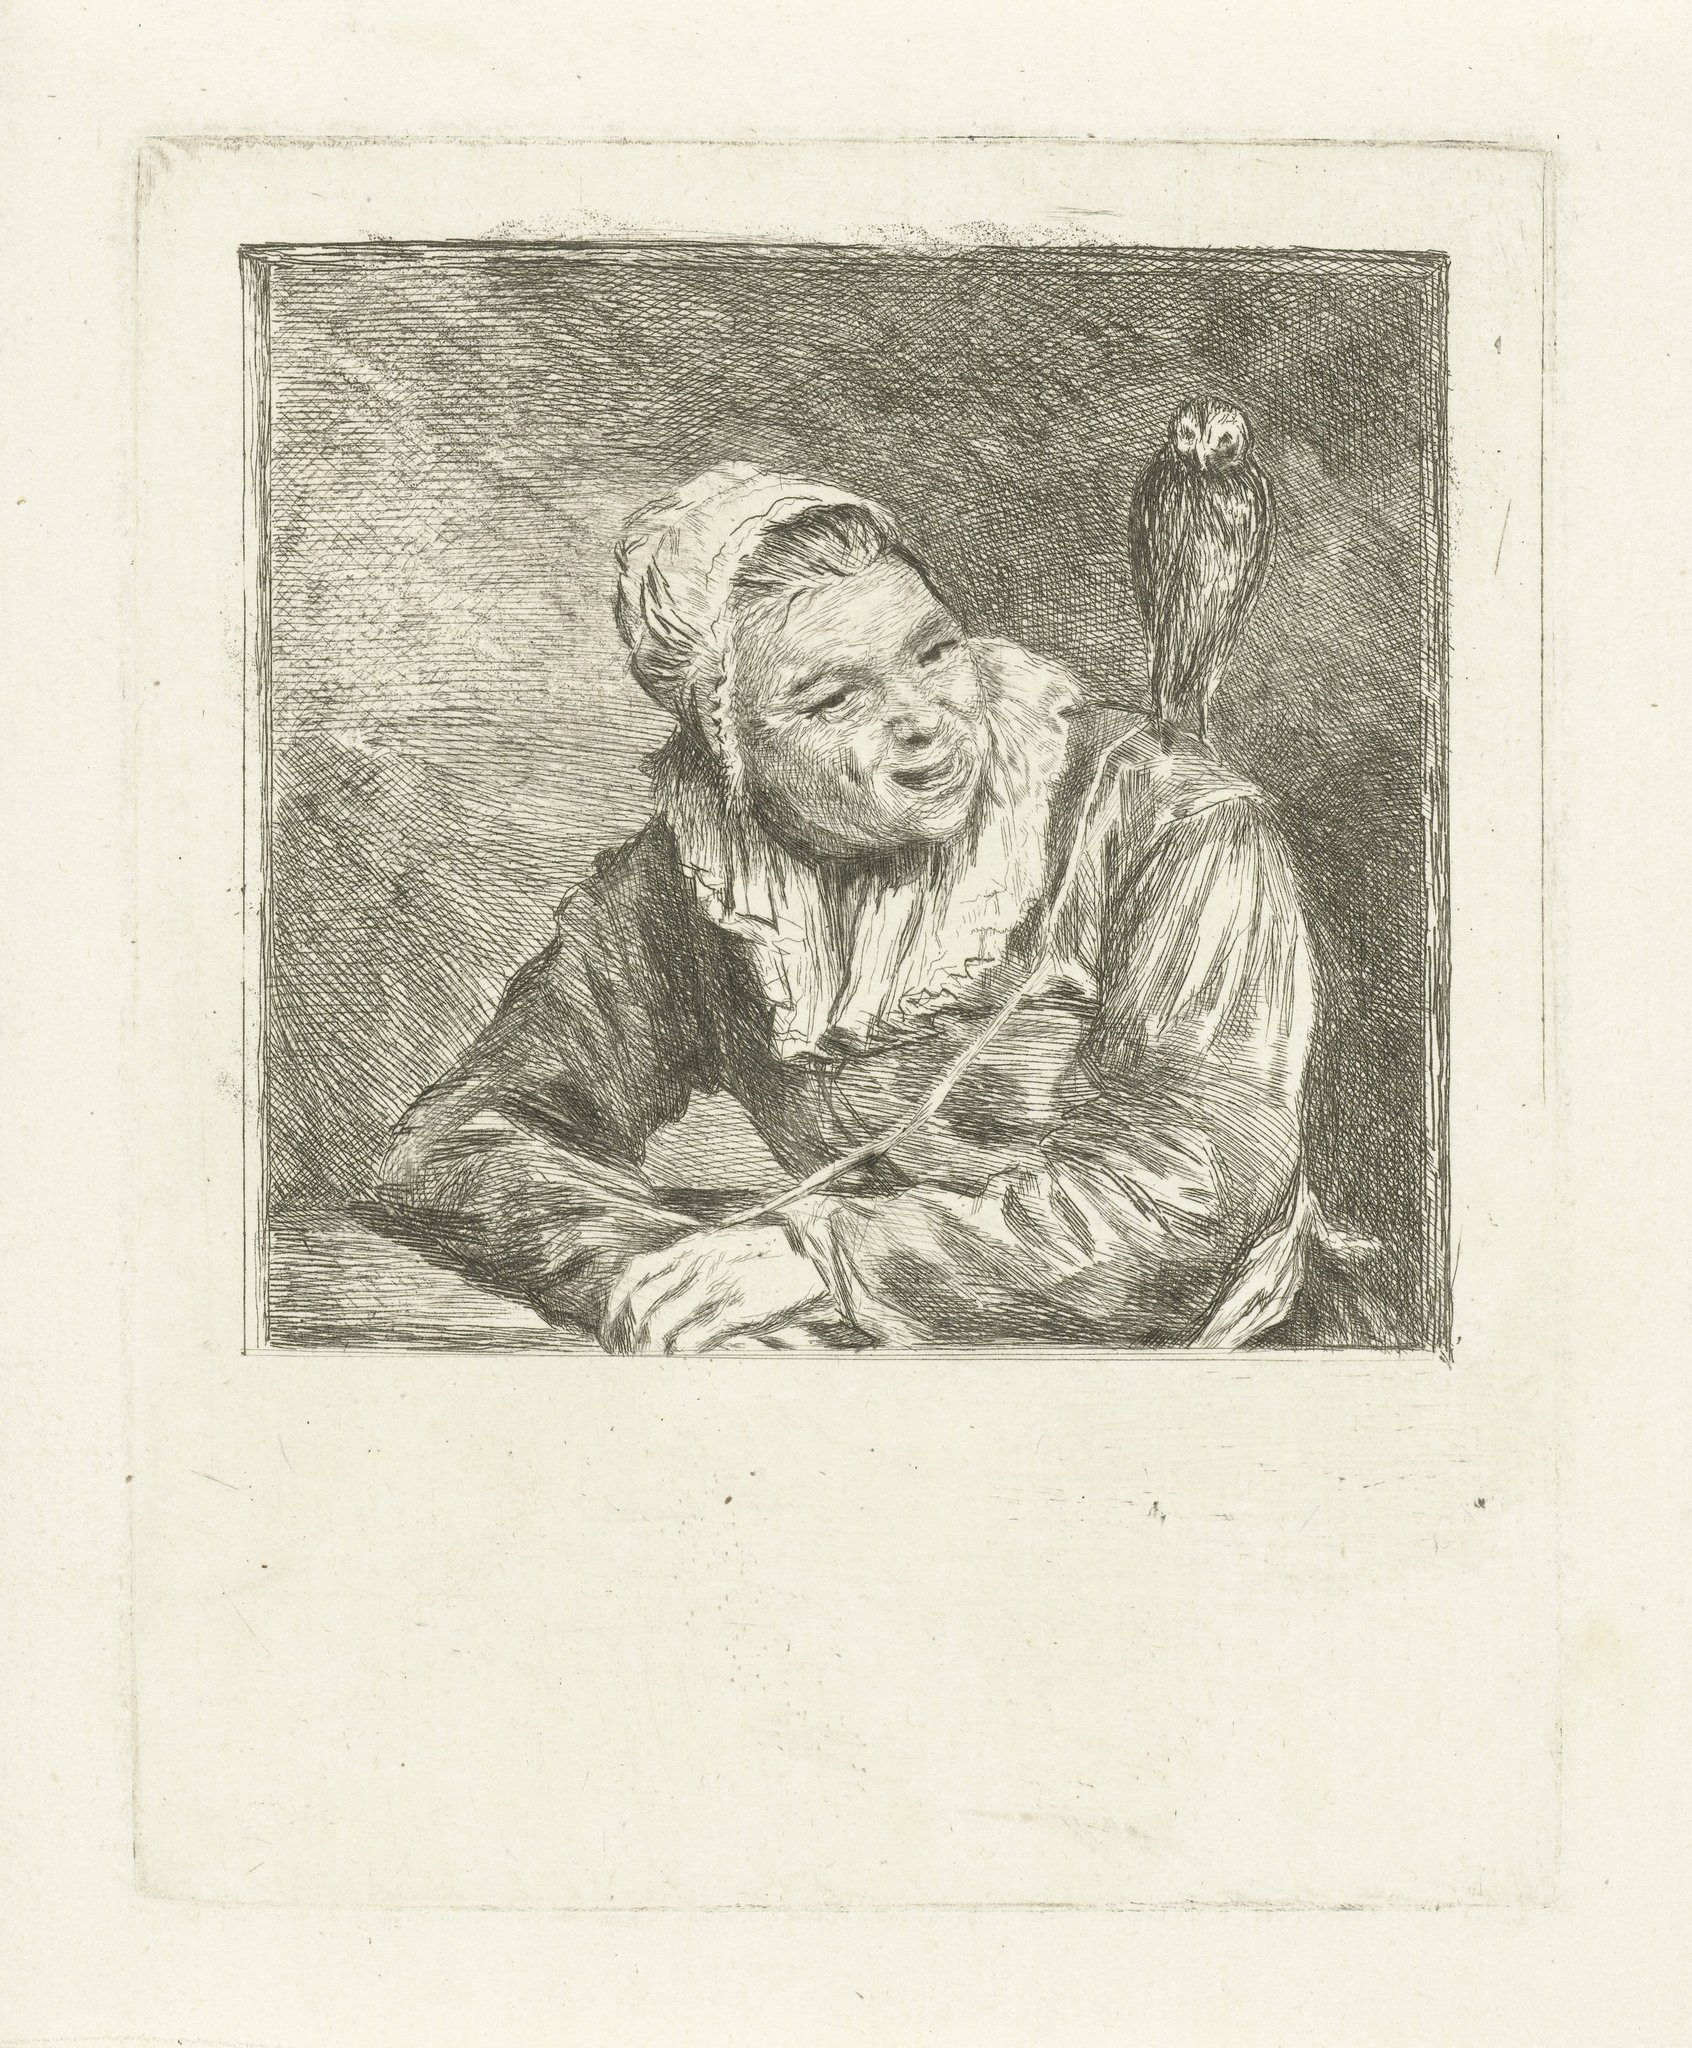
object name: print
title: Malle Babbe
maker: louis bernard coclers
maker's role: draughtsman, print maker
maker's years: 1741-1817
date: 1756-1817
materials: paper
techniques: drypoint, roulette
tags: witch, sorceress, owls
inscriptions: collector's mark: Lugt 2228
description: Portretbuste van een lachende oude vrouw met wit kapje en kraag. Op haar schouder zit een uil.